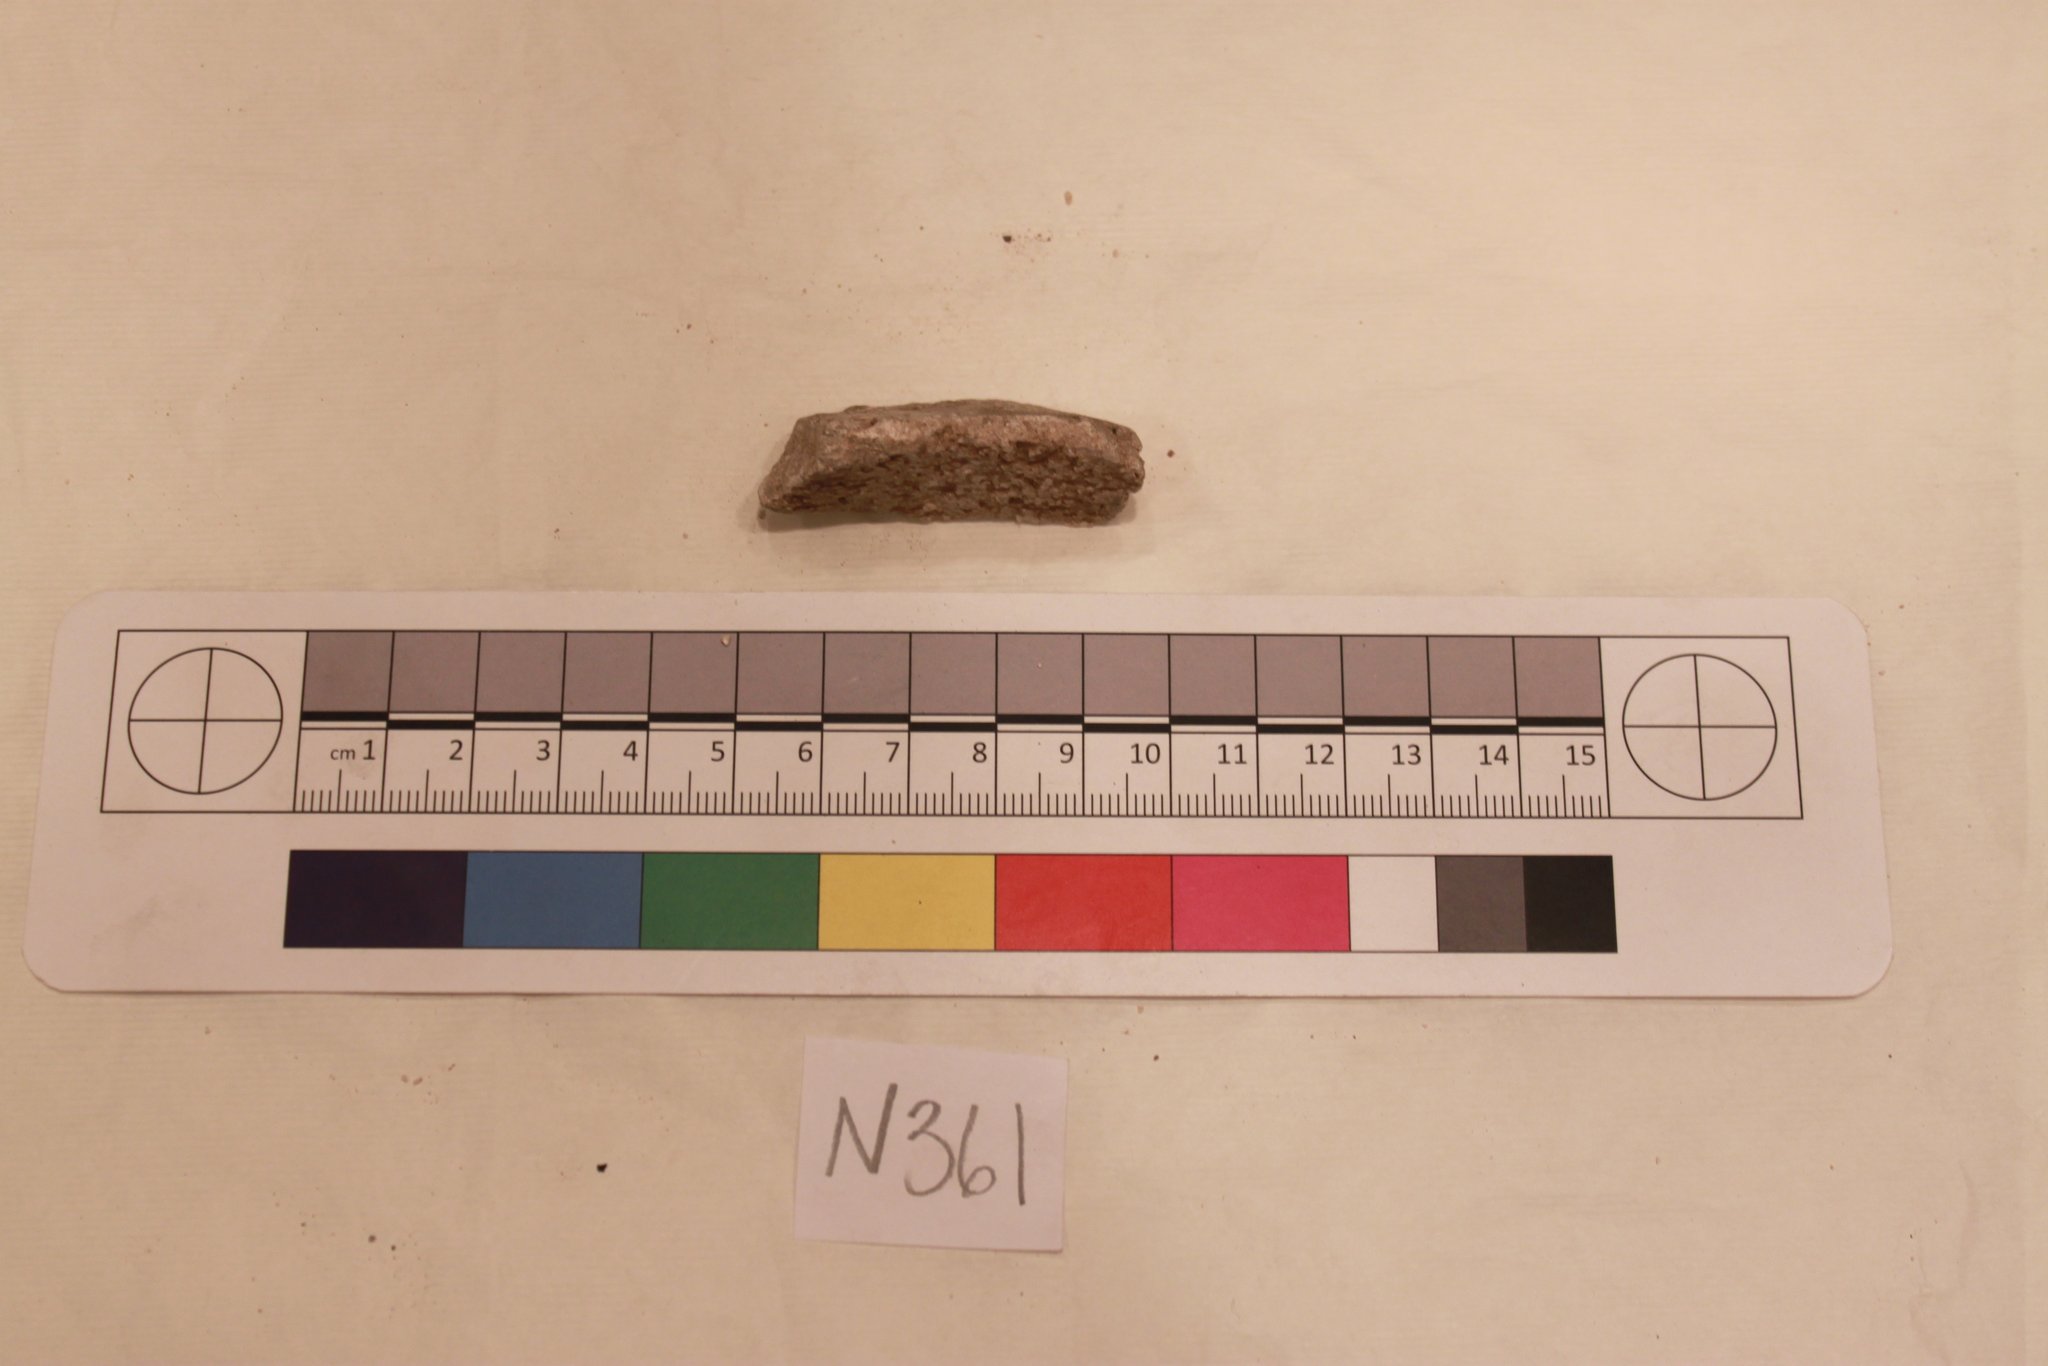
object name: fragment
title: Stucco Fragment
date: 701-1200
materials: plaster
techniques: carving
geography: iran